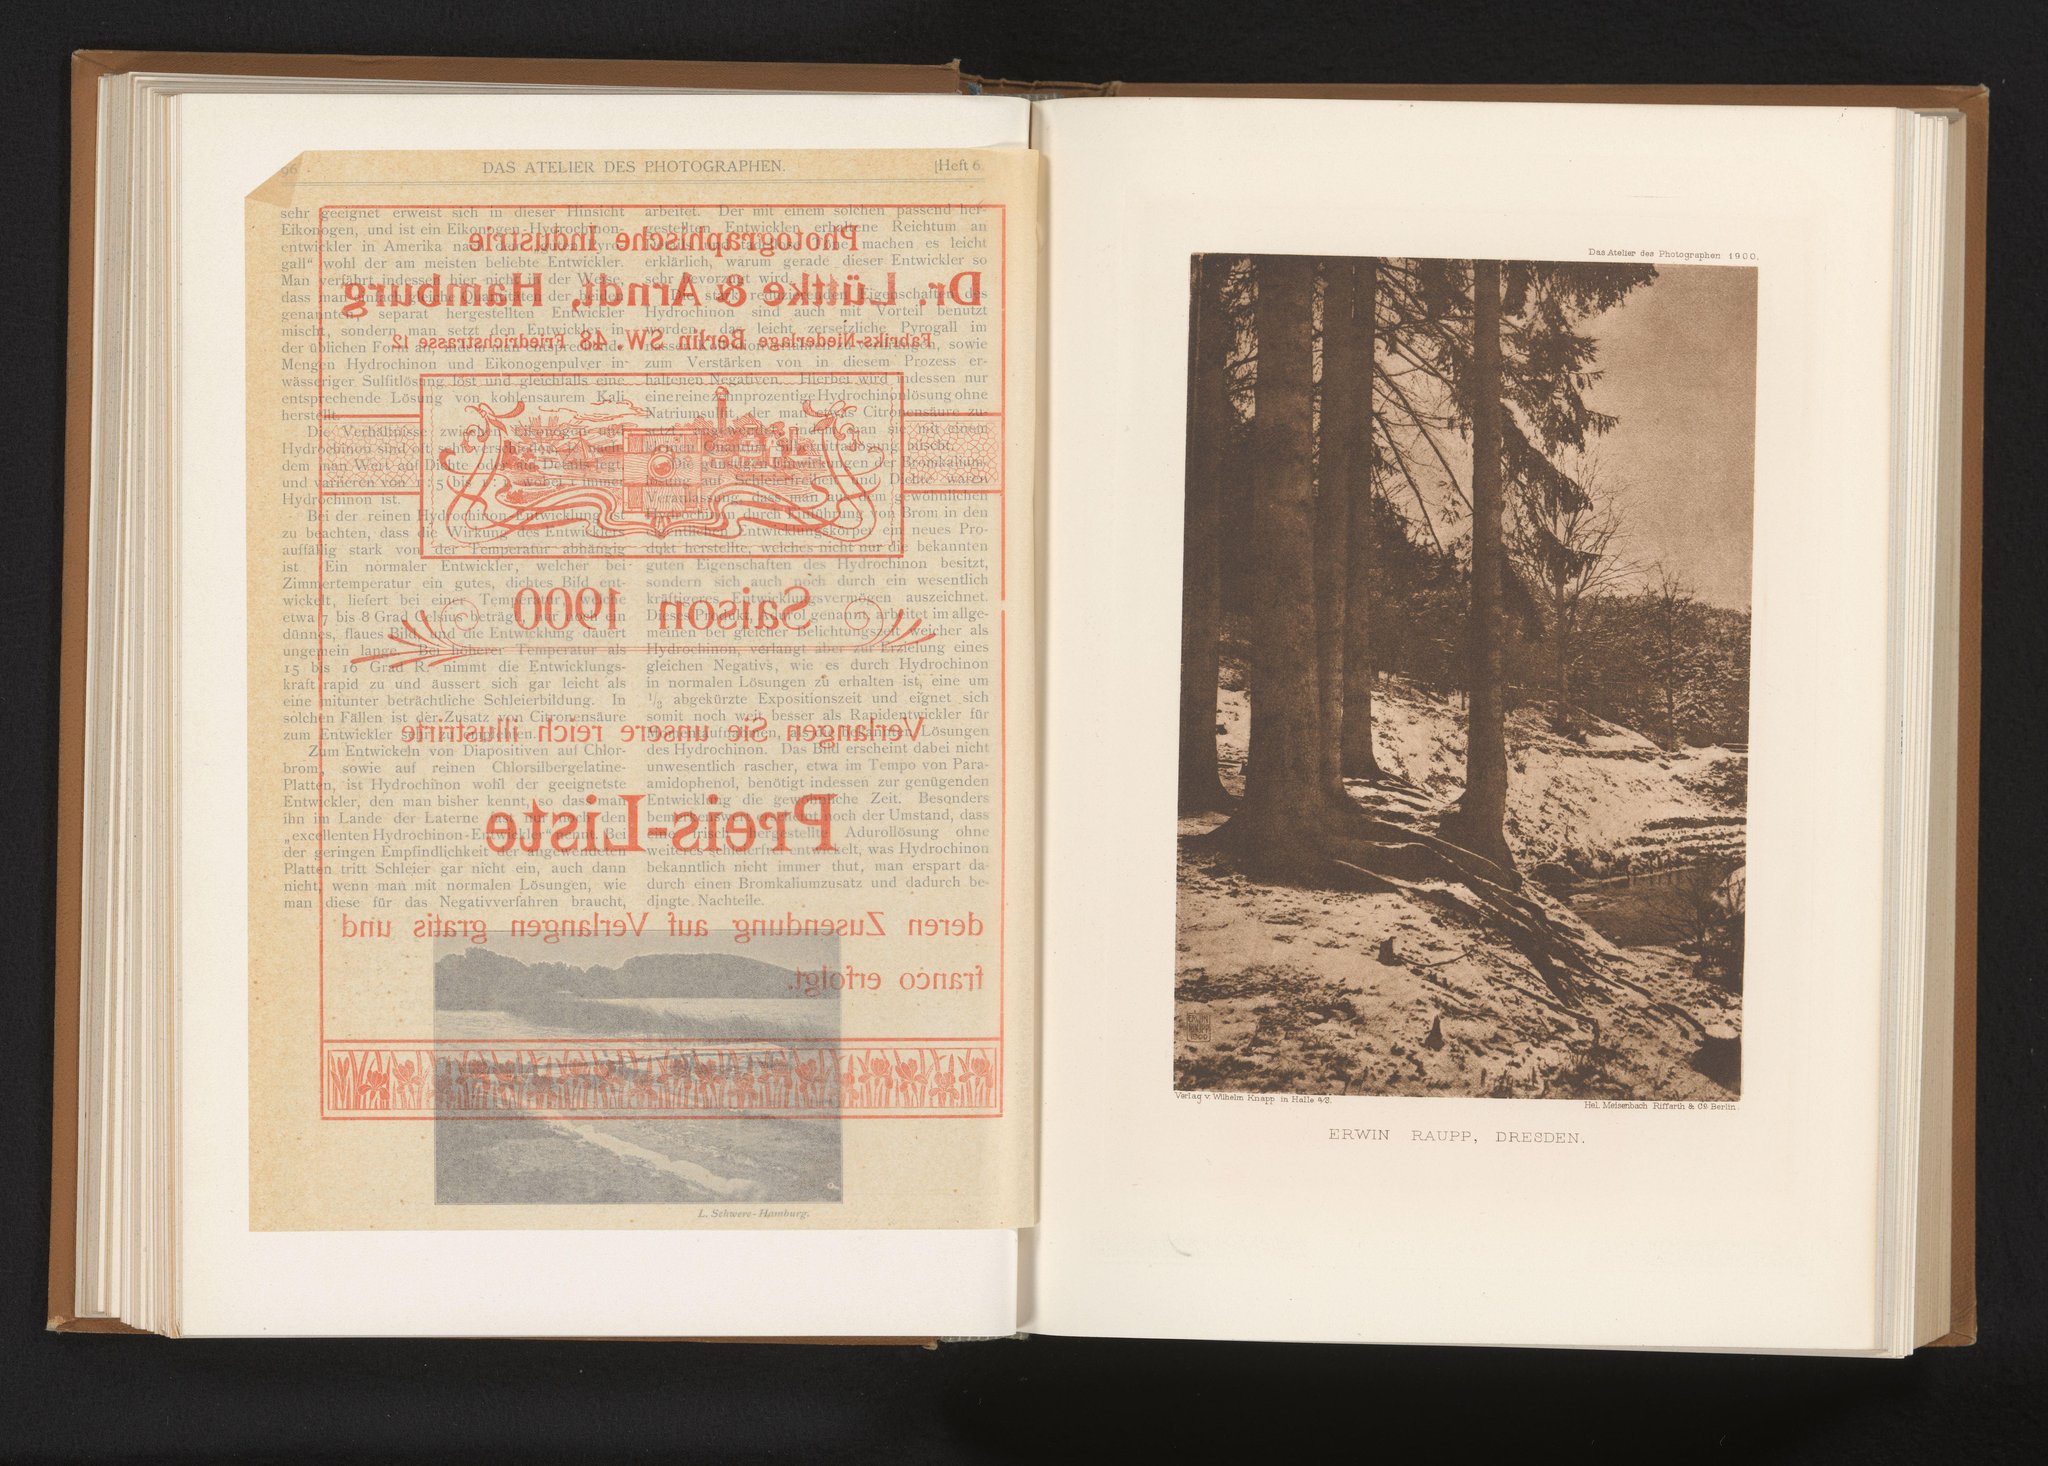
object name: page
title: Winterlandschap met bomen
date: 1900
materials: paper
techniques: photoaquatint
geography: dresden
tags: trees, winter landscape; landscape symbolizing winter (the four seasons of the year)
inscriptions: inscription: ‘Das Atelier des Photographen 1900.’